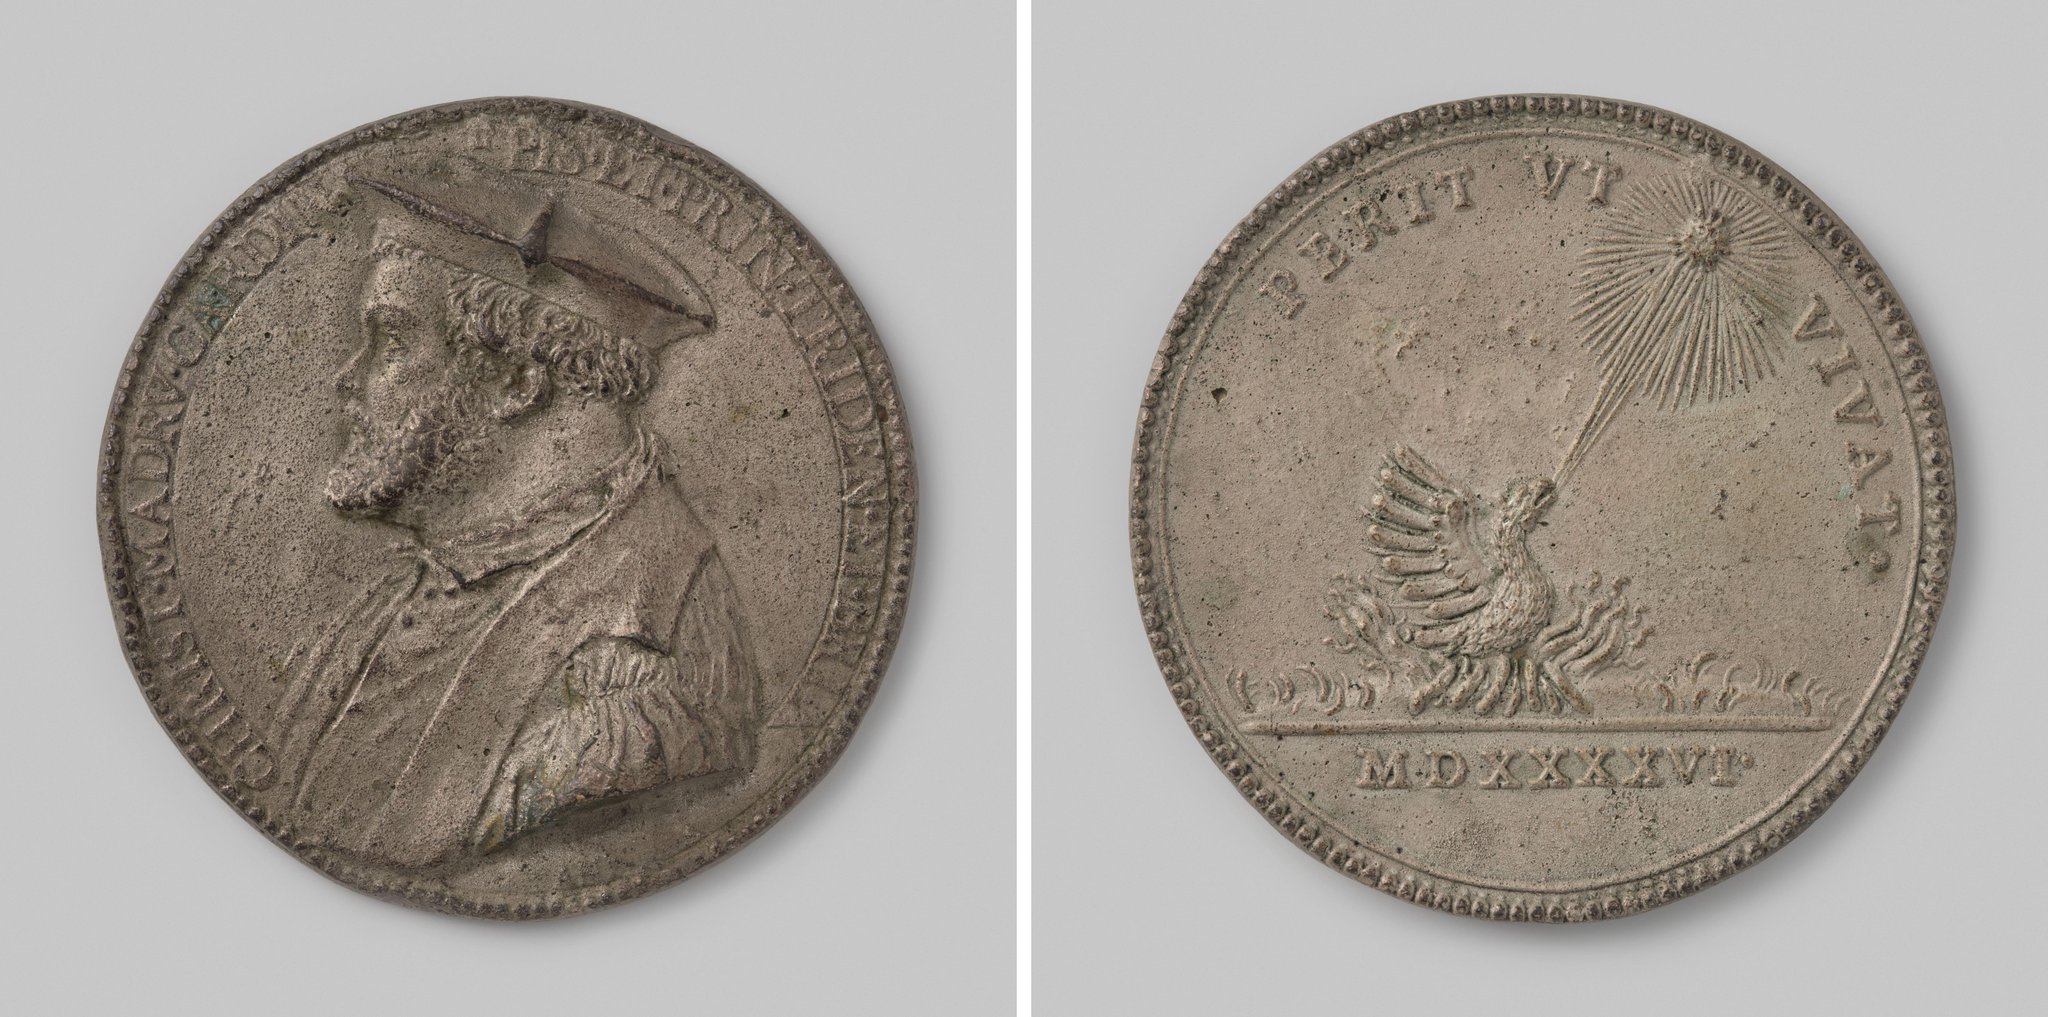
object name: copy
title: Kardinaal Cristoforo Madruzzo, bisschop van Trente en Brixen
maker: annizatti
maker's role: sculptor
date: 1557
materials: bronze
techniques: casting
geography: italy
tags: kardinaal, cristoforo madruzzo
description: Bronzen penning. Voorzijde: borststuk man binnen omschrift. Keerzijde: zonnestralen doen hout ontbranden onder een phoenix binnen omschrift; afsnede: jaartal